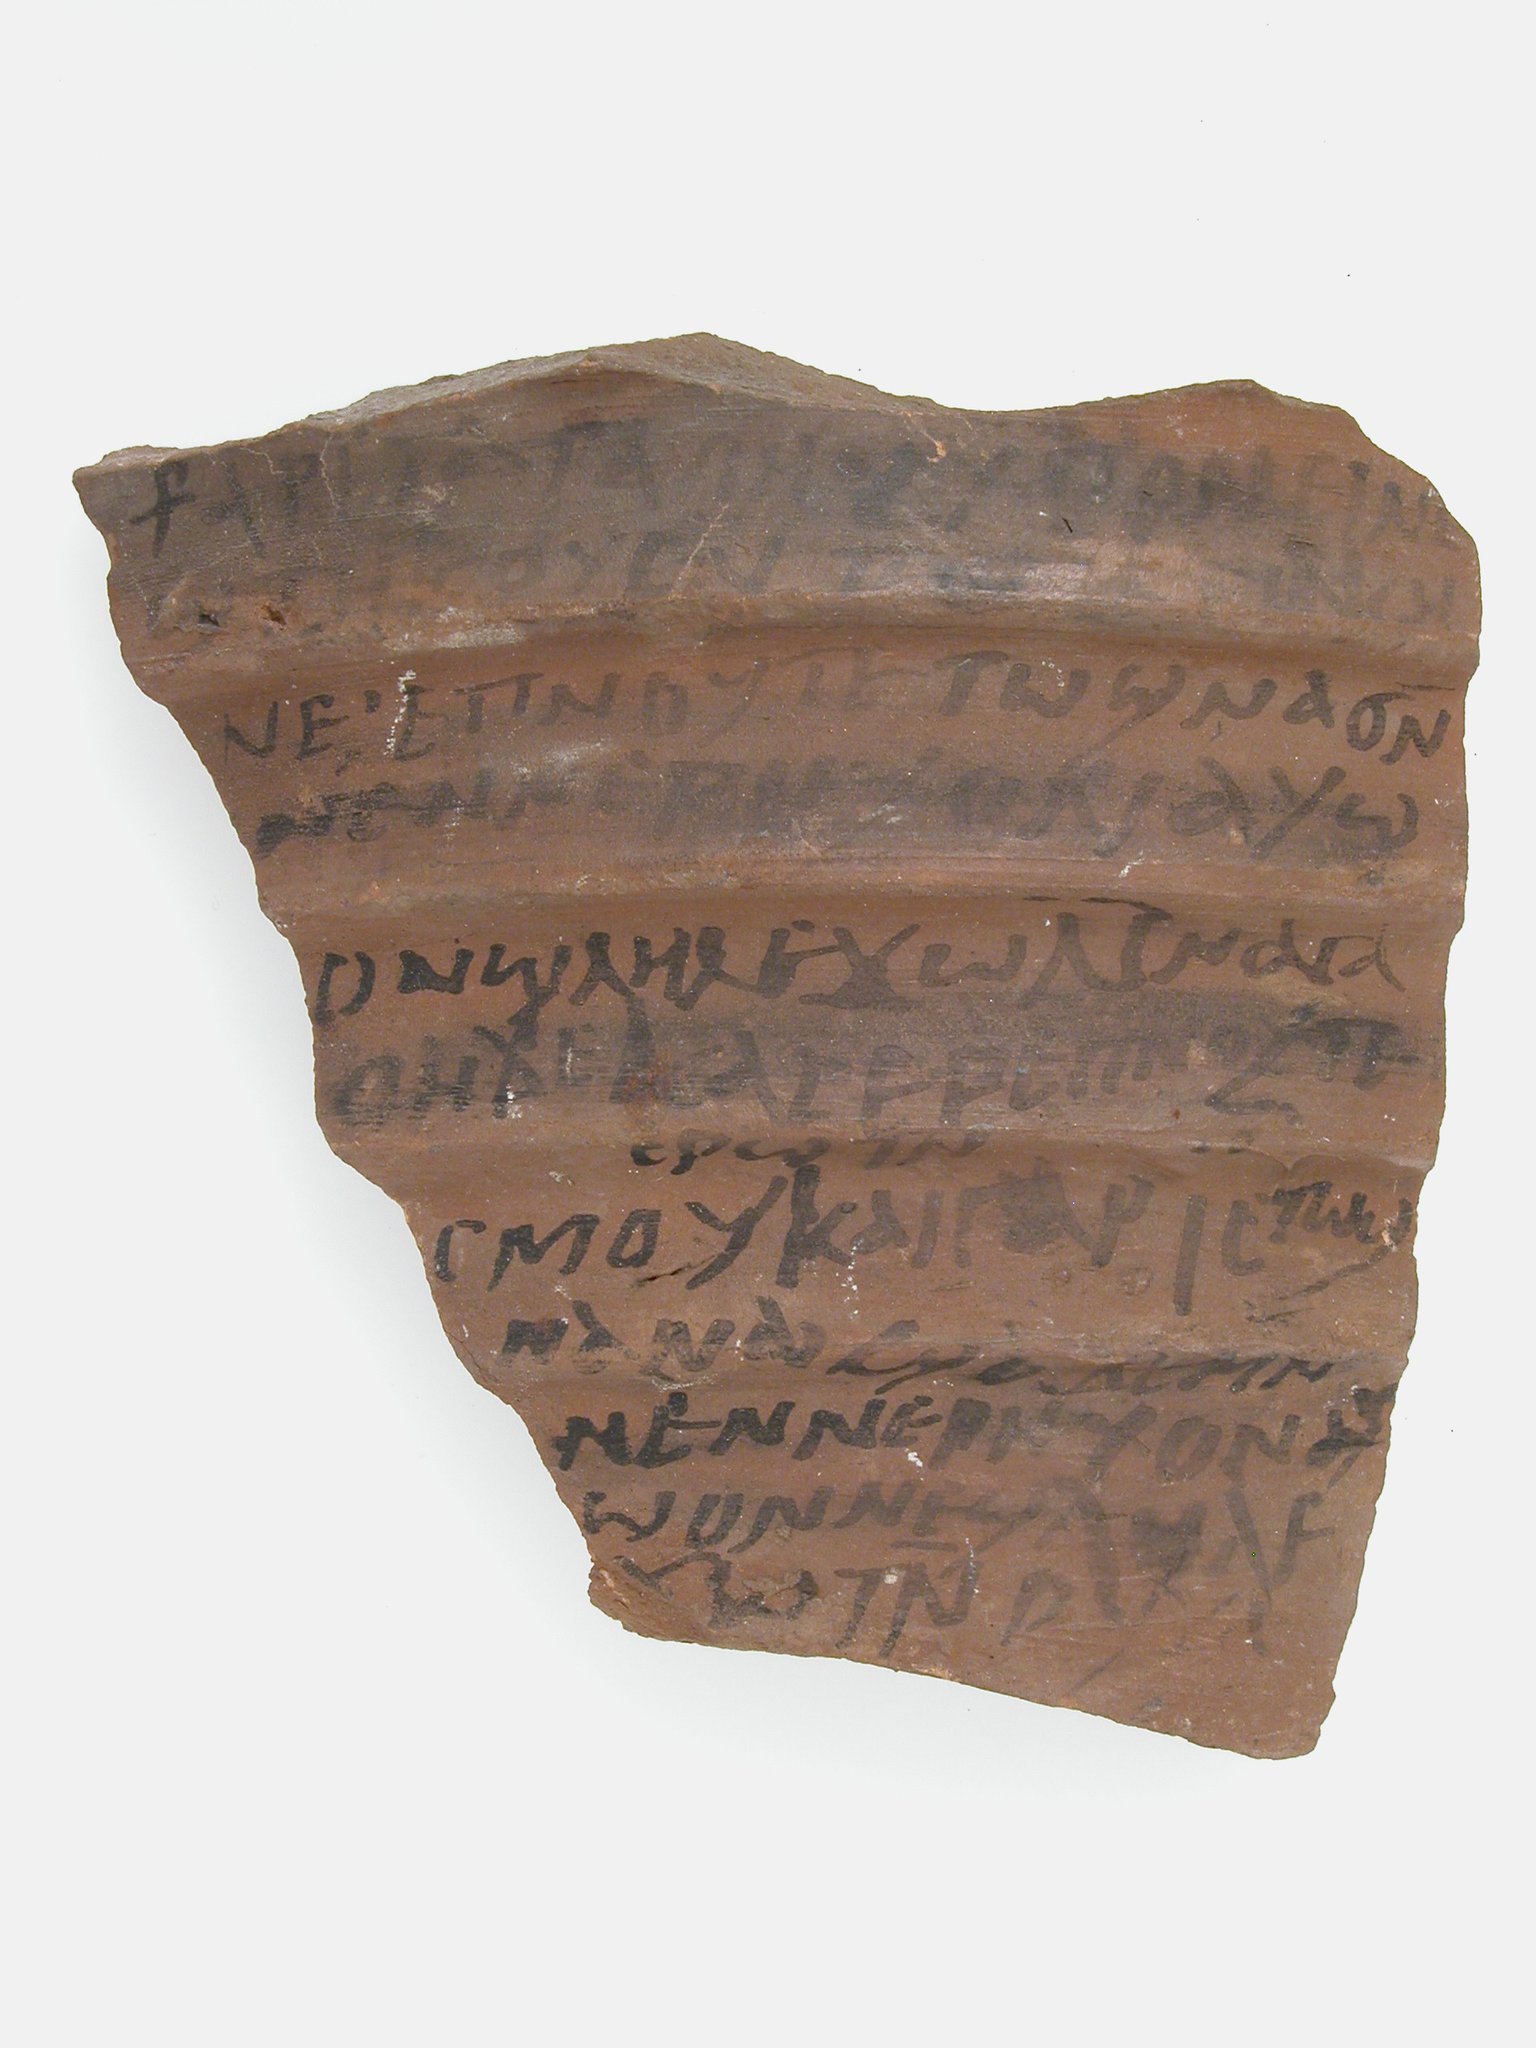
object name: ostrakon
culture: coptic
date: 601-700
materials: ink, pottery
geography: egypt